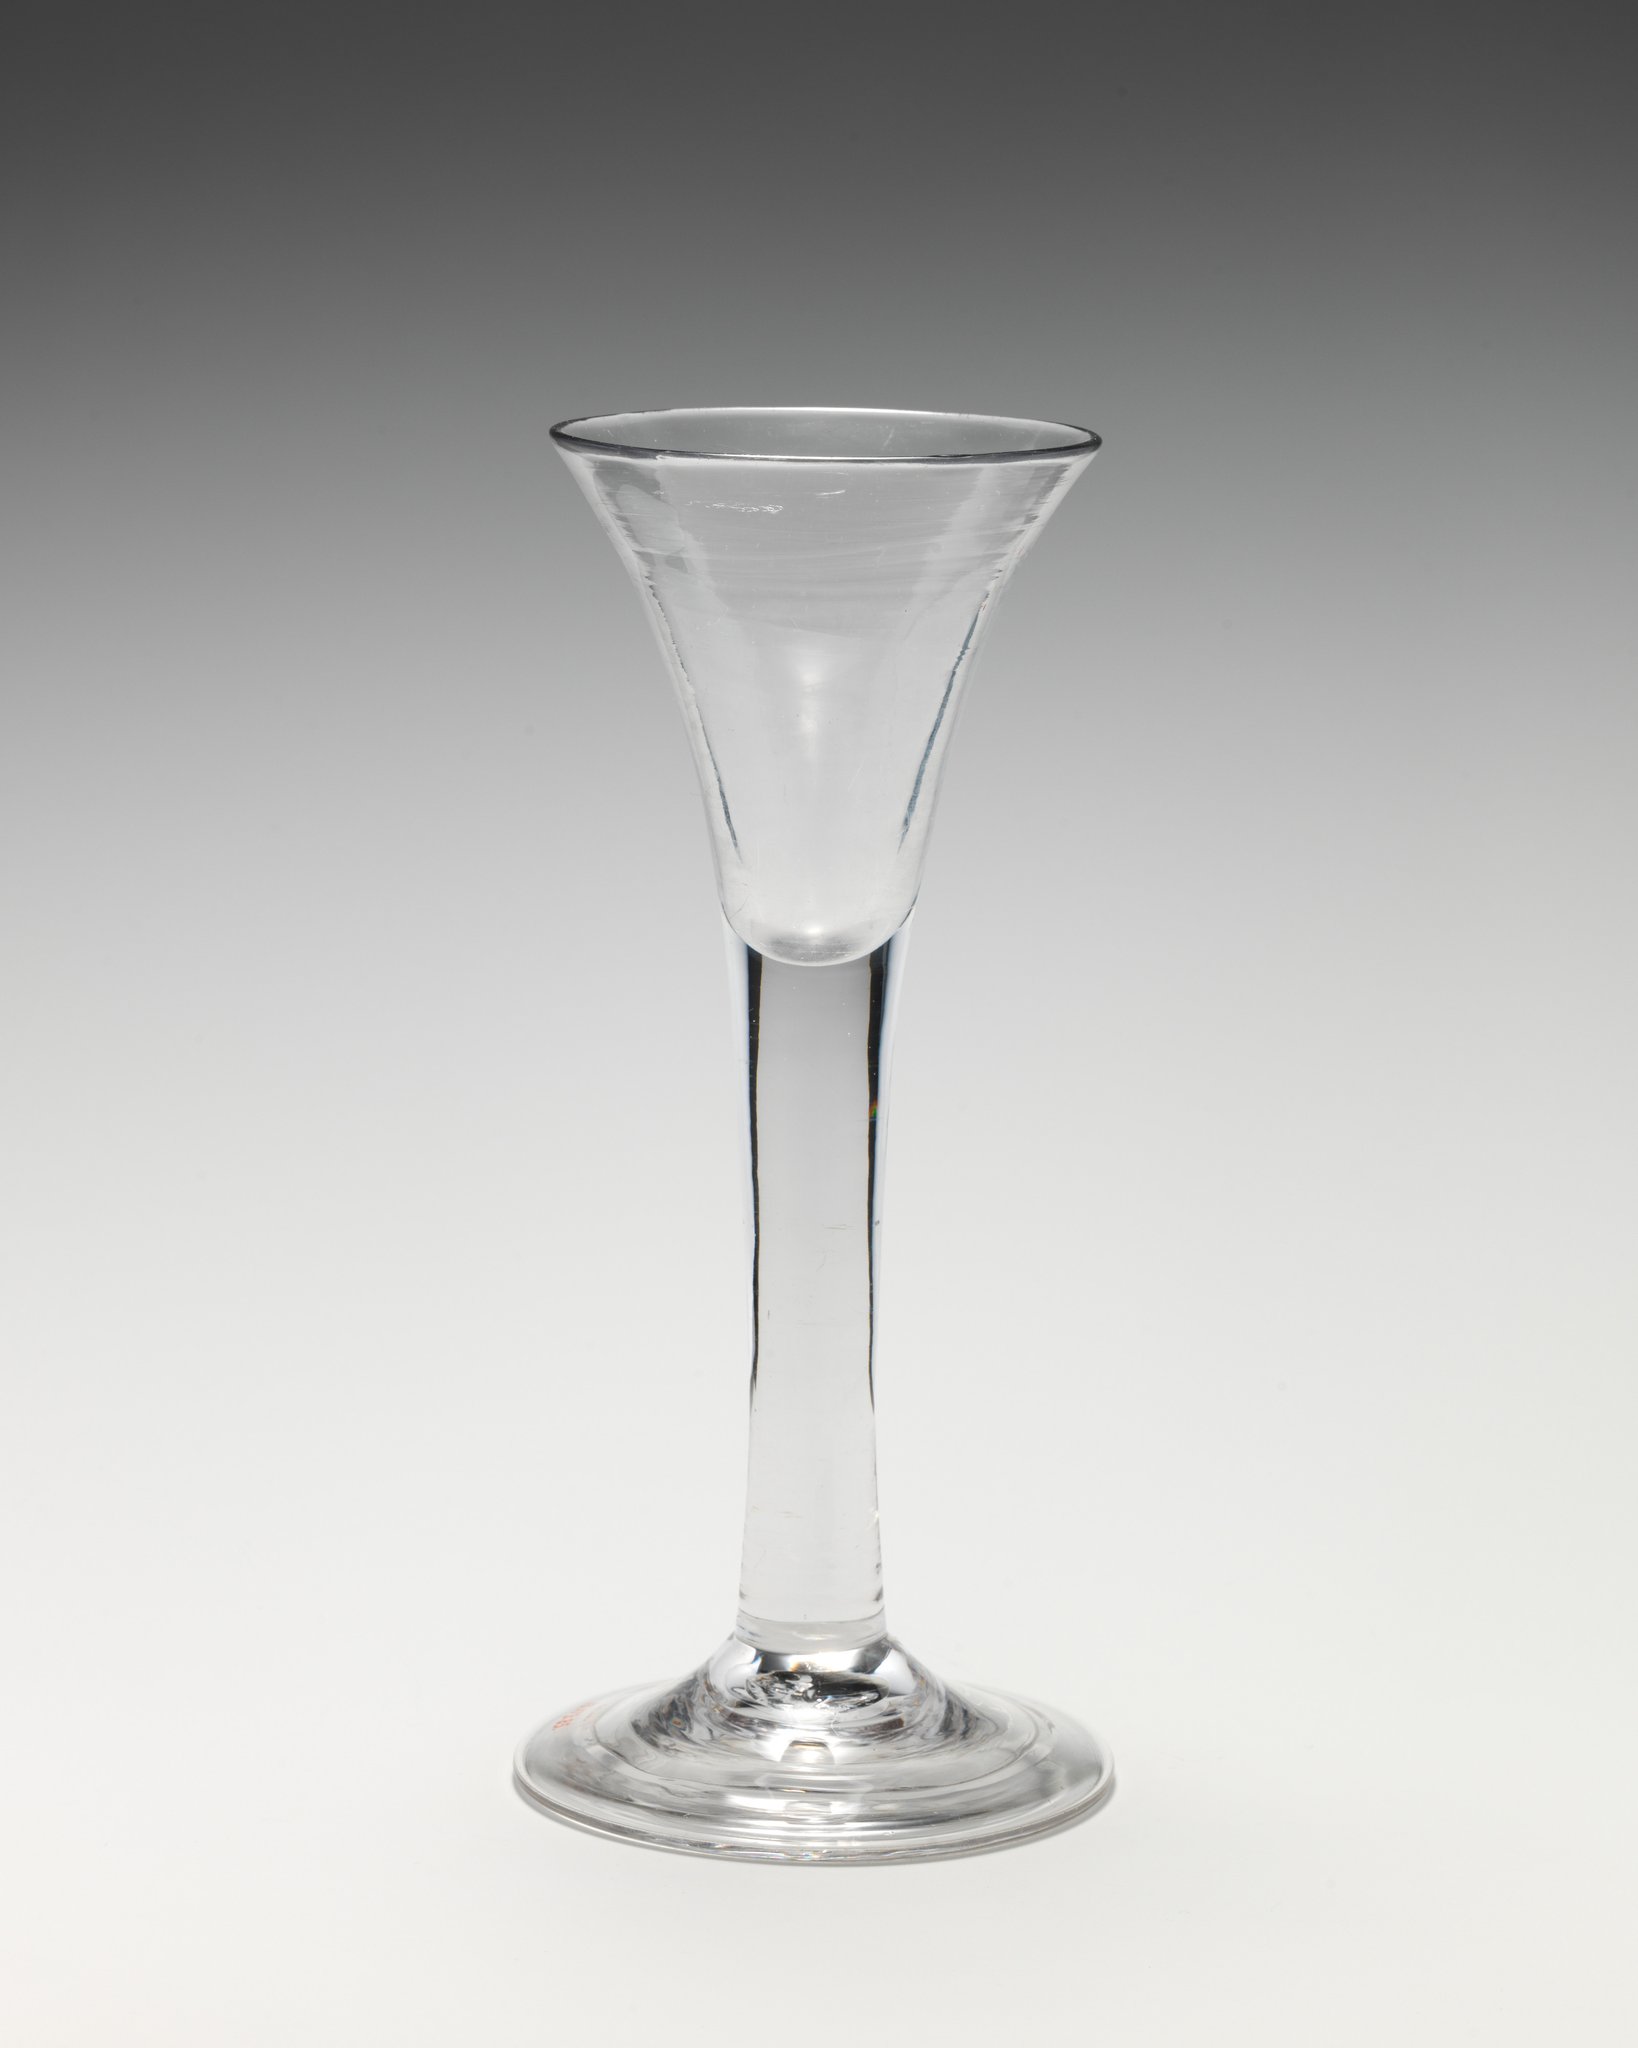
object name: wineglass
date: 1720-1740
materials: glass